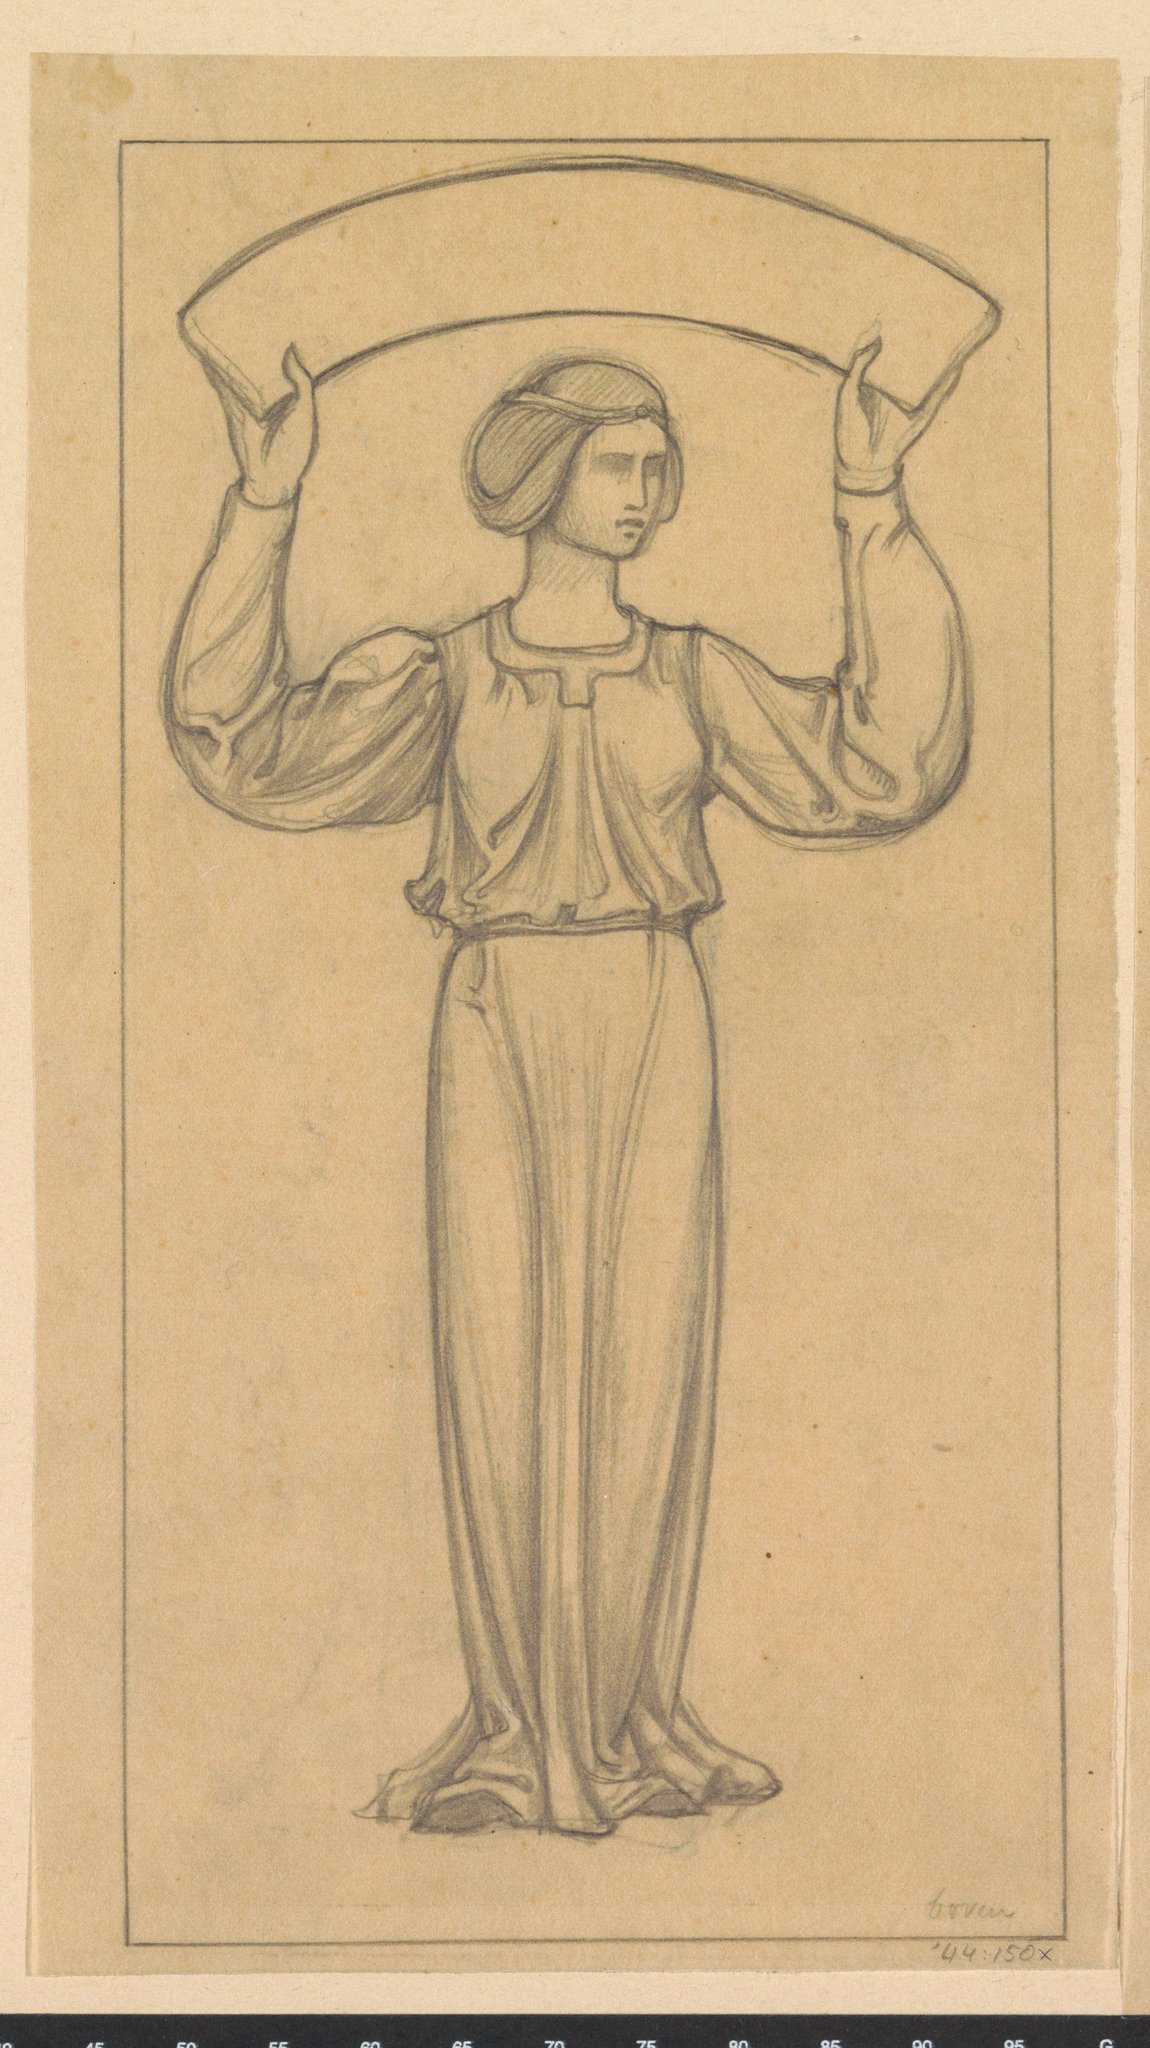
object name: tracing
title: Ontwerp voor wandschildering in de Beurs van Berlage: staande vrouw met banderol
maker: antoon derkinderen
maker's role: draughtsman, painter, print maker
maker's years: 1859-1925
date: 1869-1925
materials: pencil, paper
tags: banderole